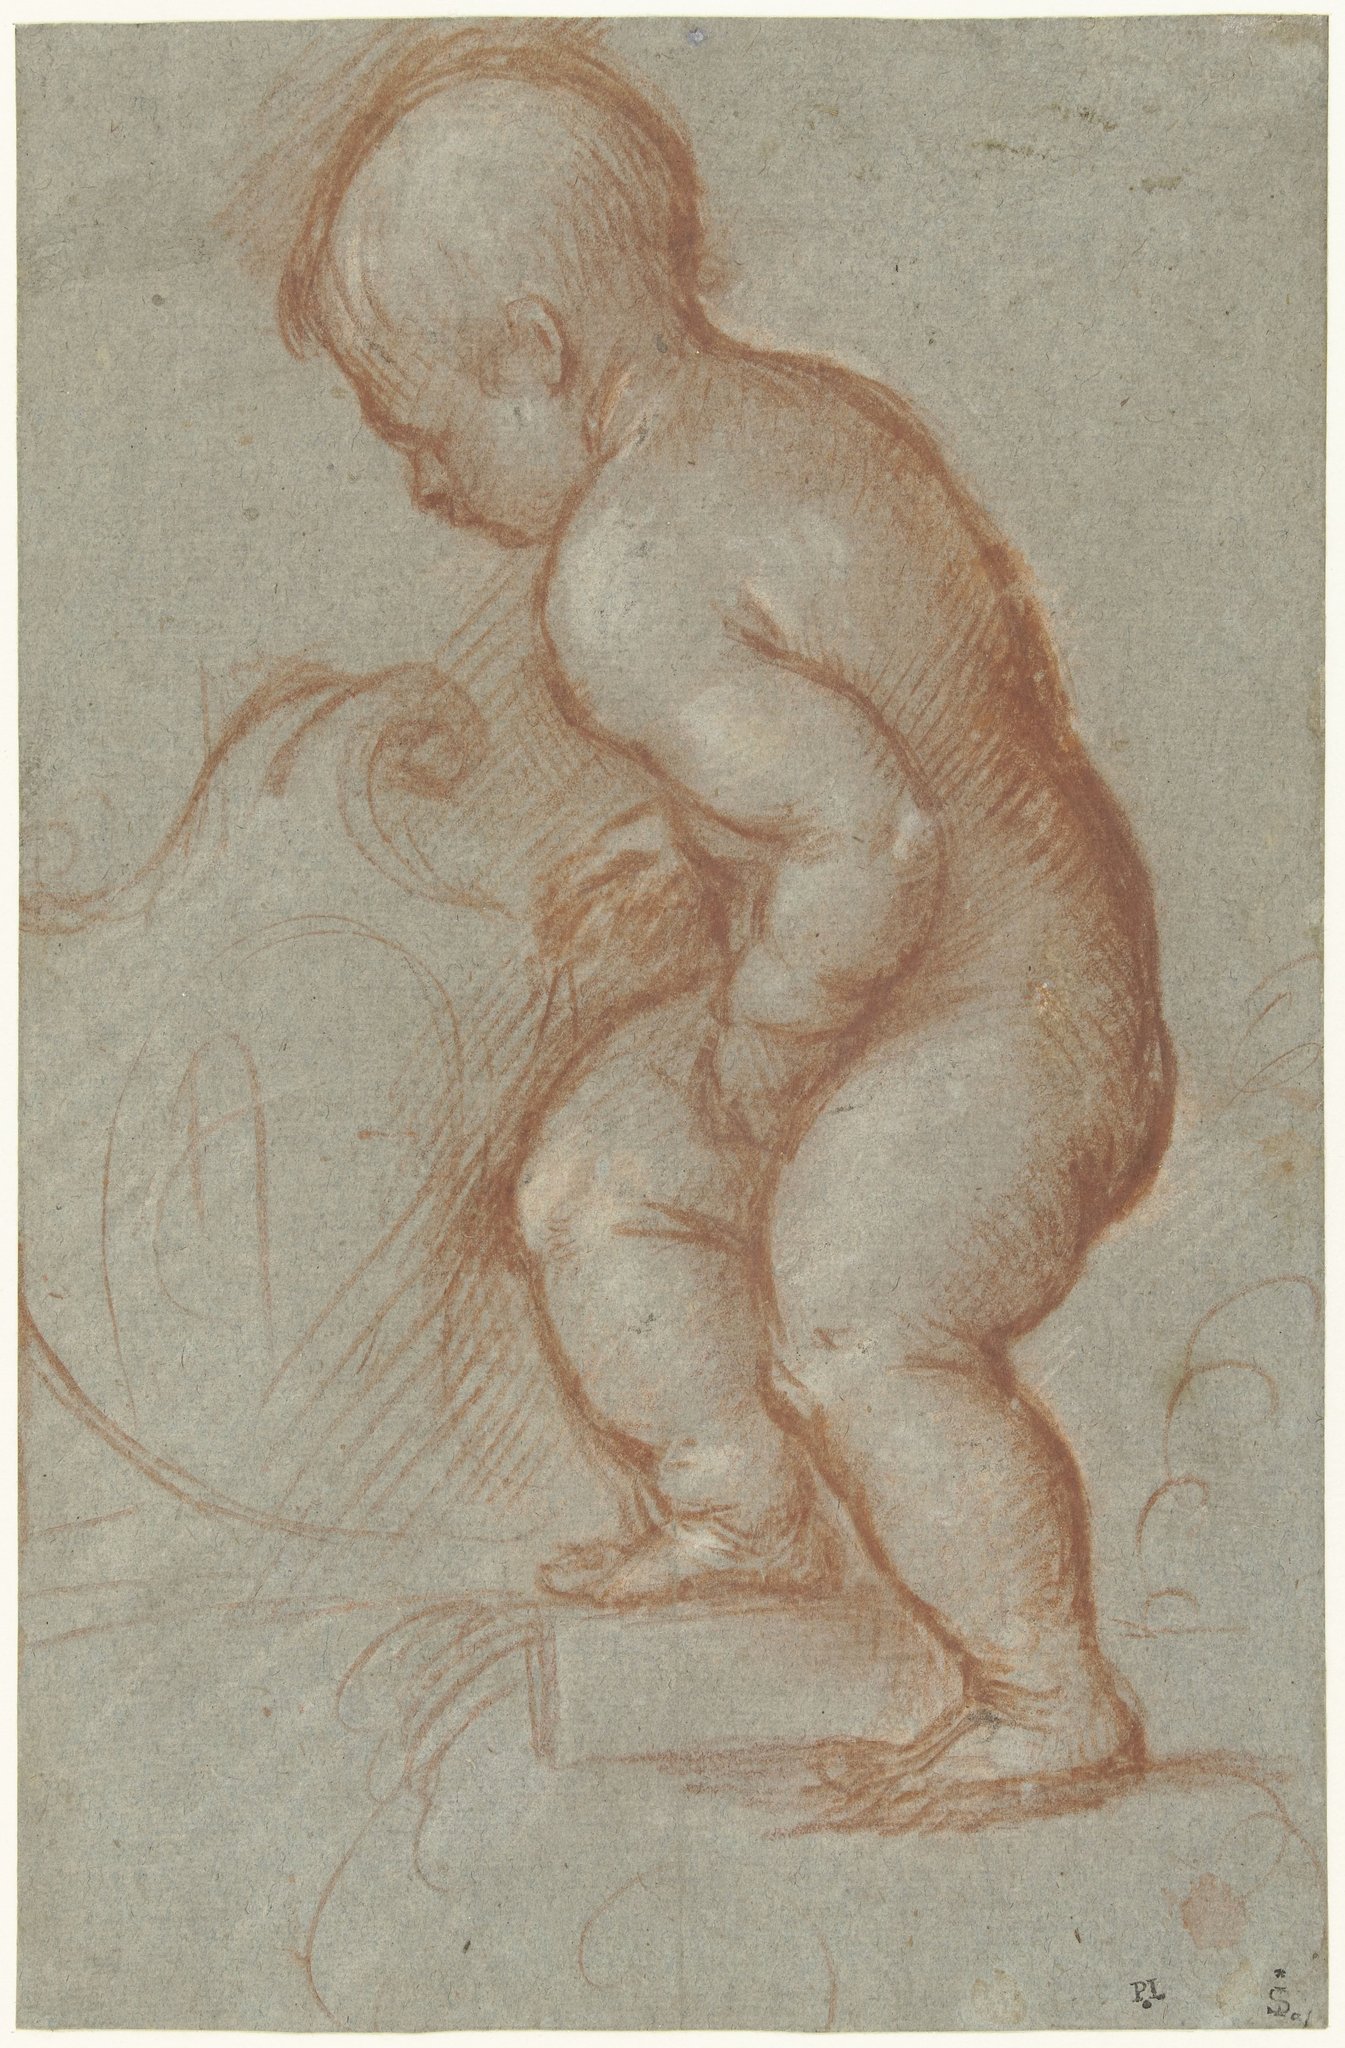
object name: drawing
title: Putto met een wapenschild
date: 1520-1539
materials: chalk, paper